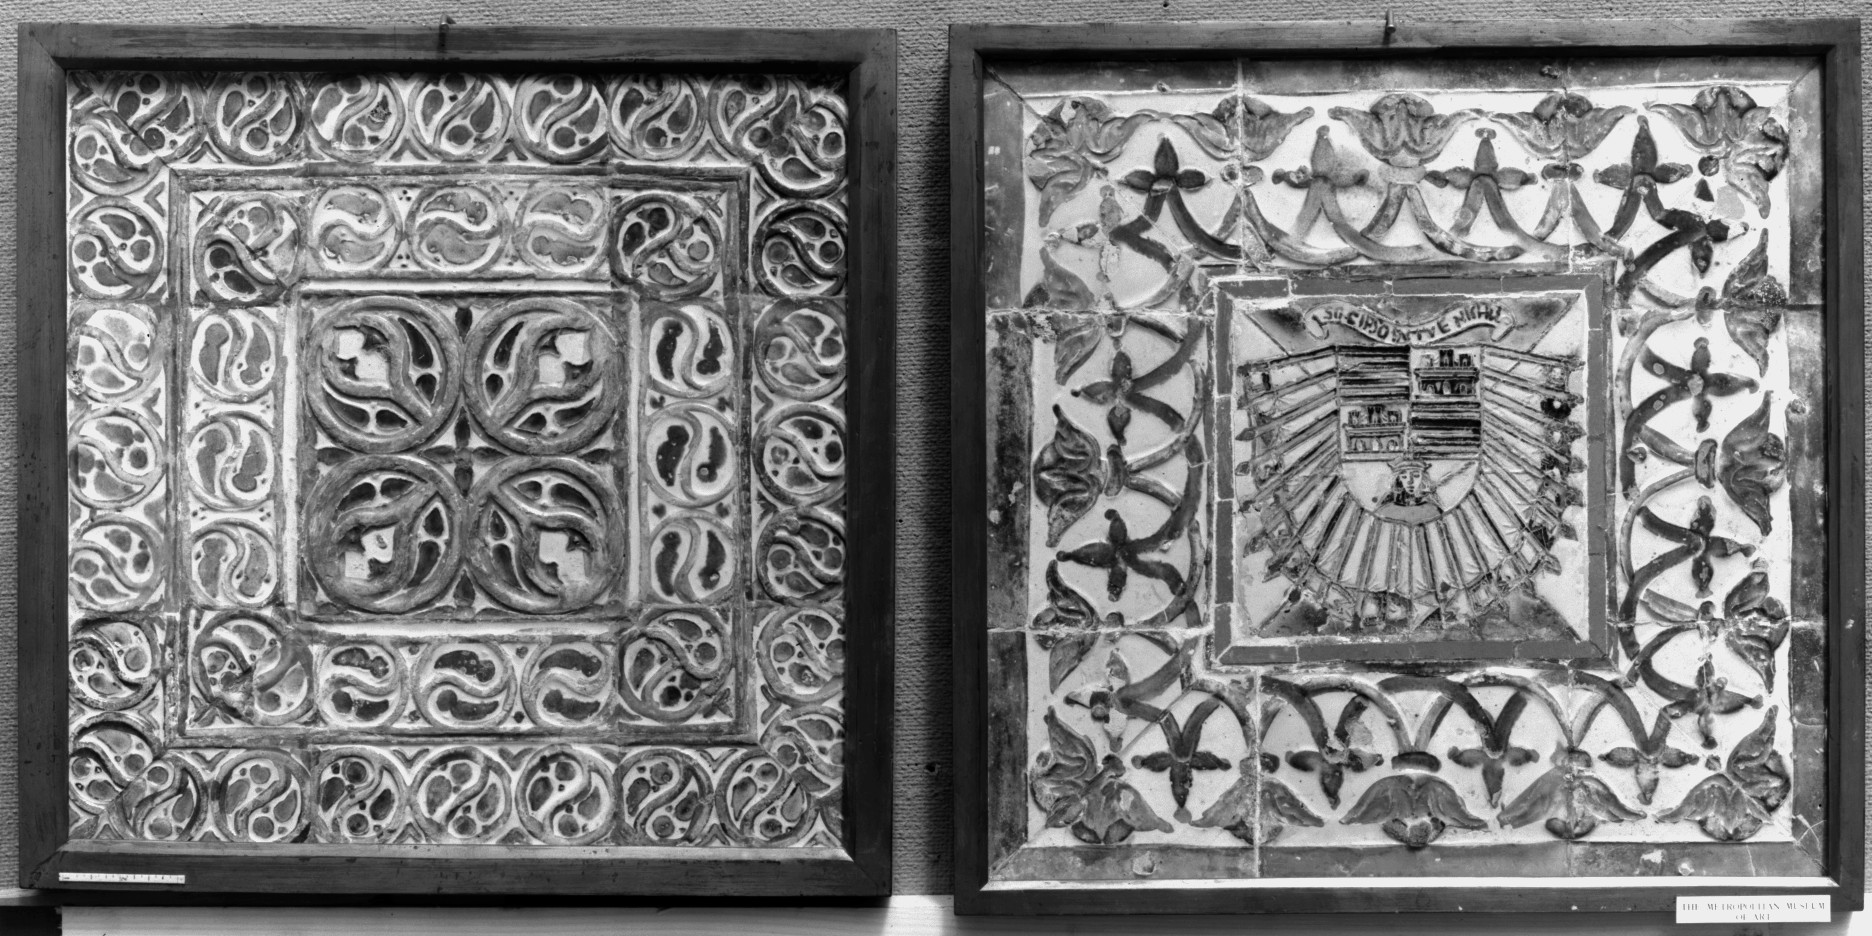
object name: tile panel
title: Wall panel tiles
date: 1501-1600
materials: earthenware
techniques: luster painting, glazing